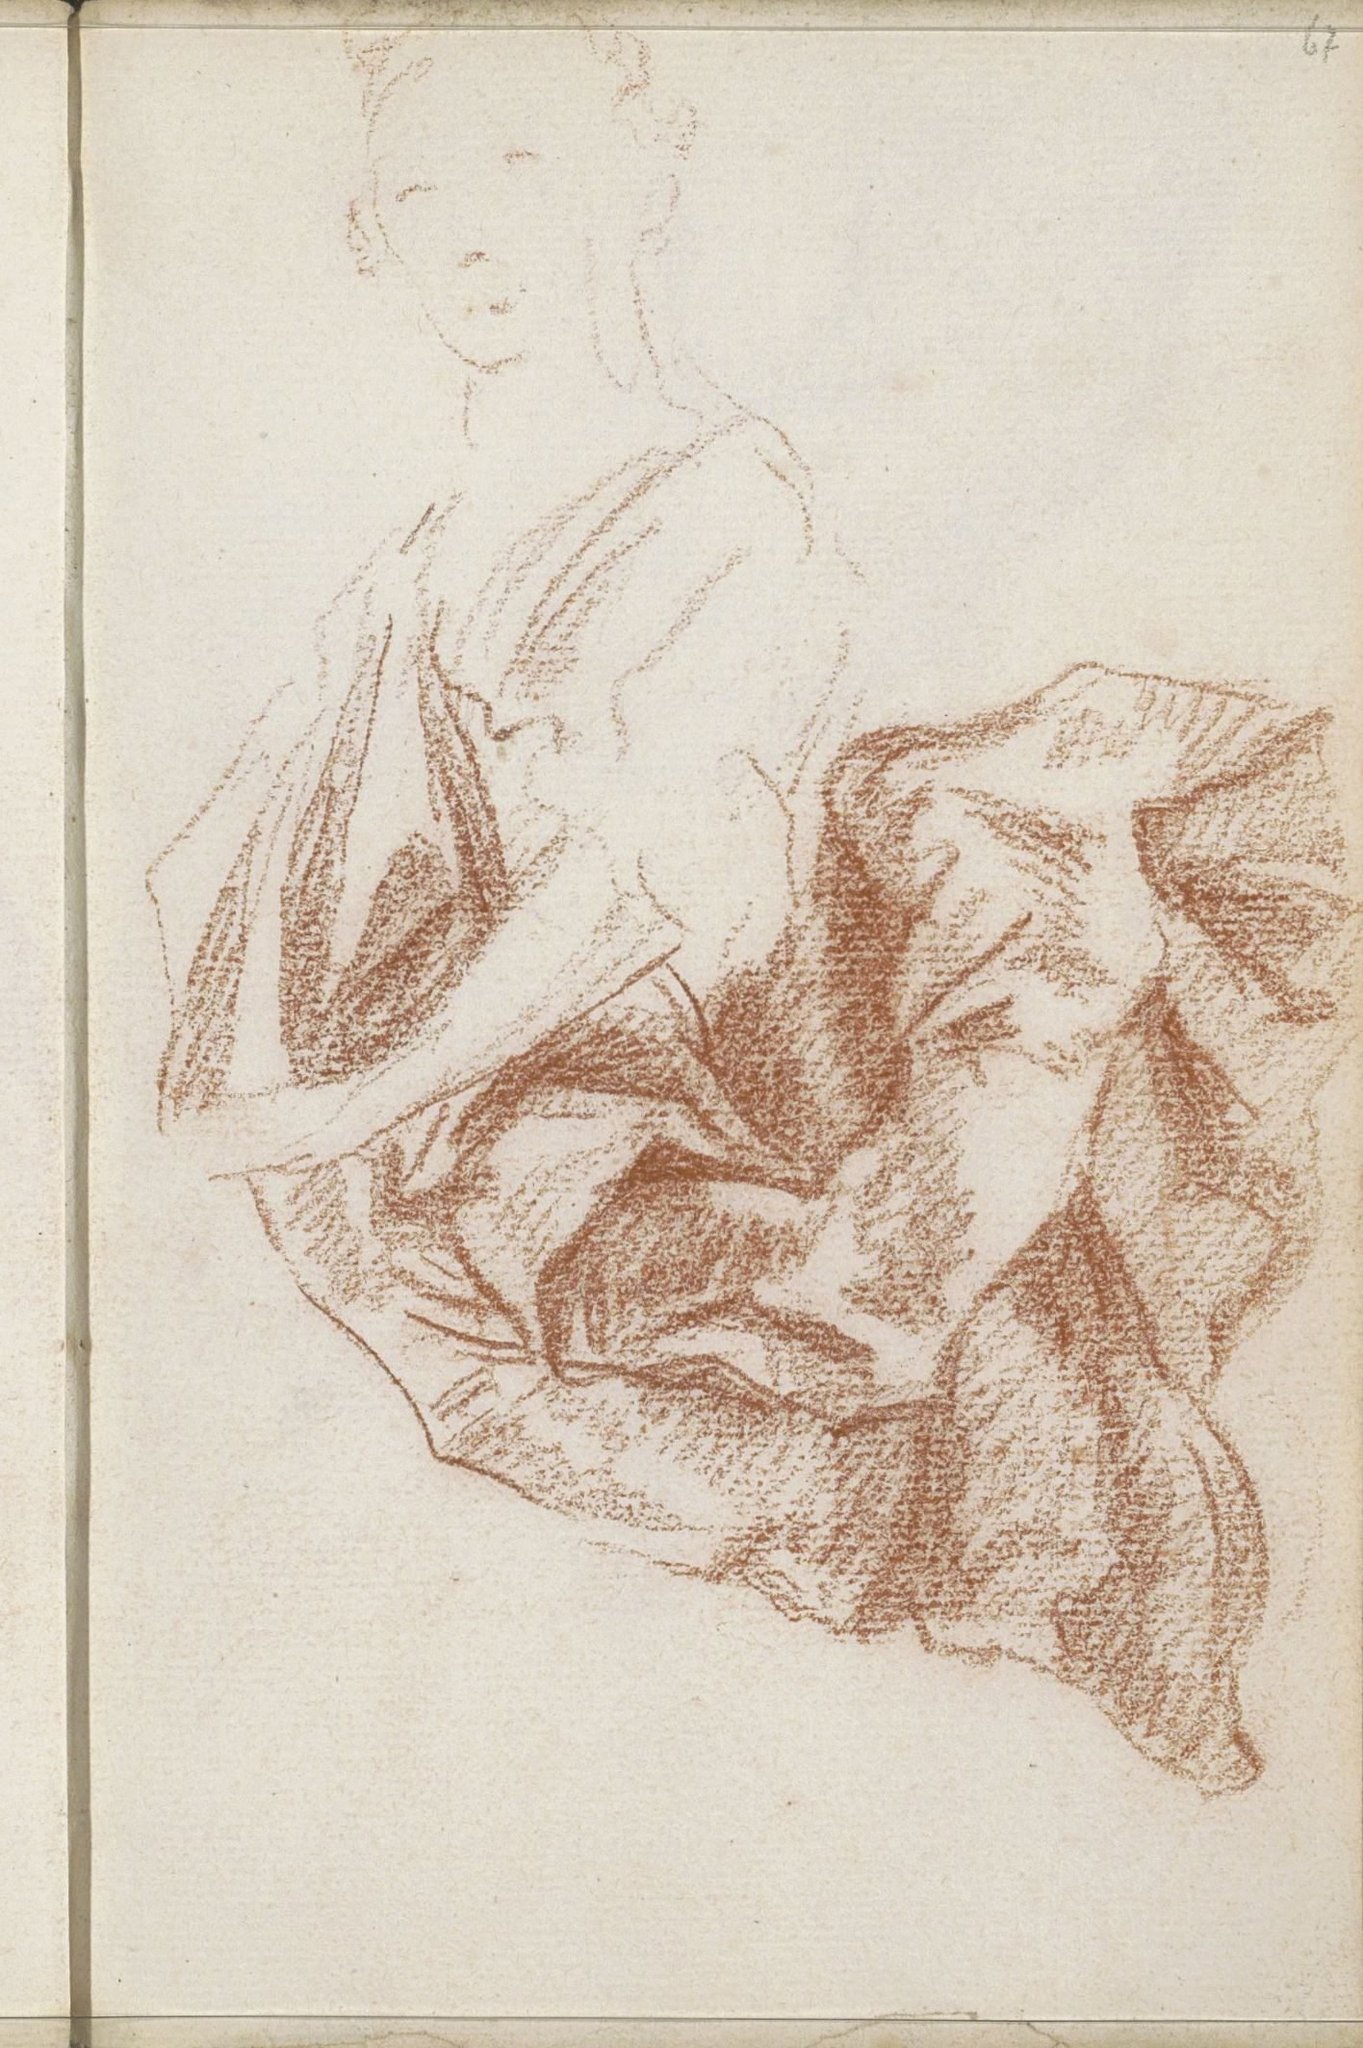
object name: sketchbook leaf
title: Vrouw met draperie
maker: petrus johannes van reysschoot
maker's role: draughtsman, print maker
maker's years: 1702-1772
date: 1710-1772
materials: chalk, paper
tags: anatomy (non-medical), drapery, draped garment, 'gewandgebung'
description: Blad 67 recto uit een schetsboek met 105 bladen.